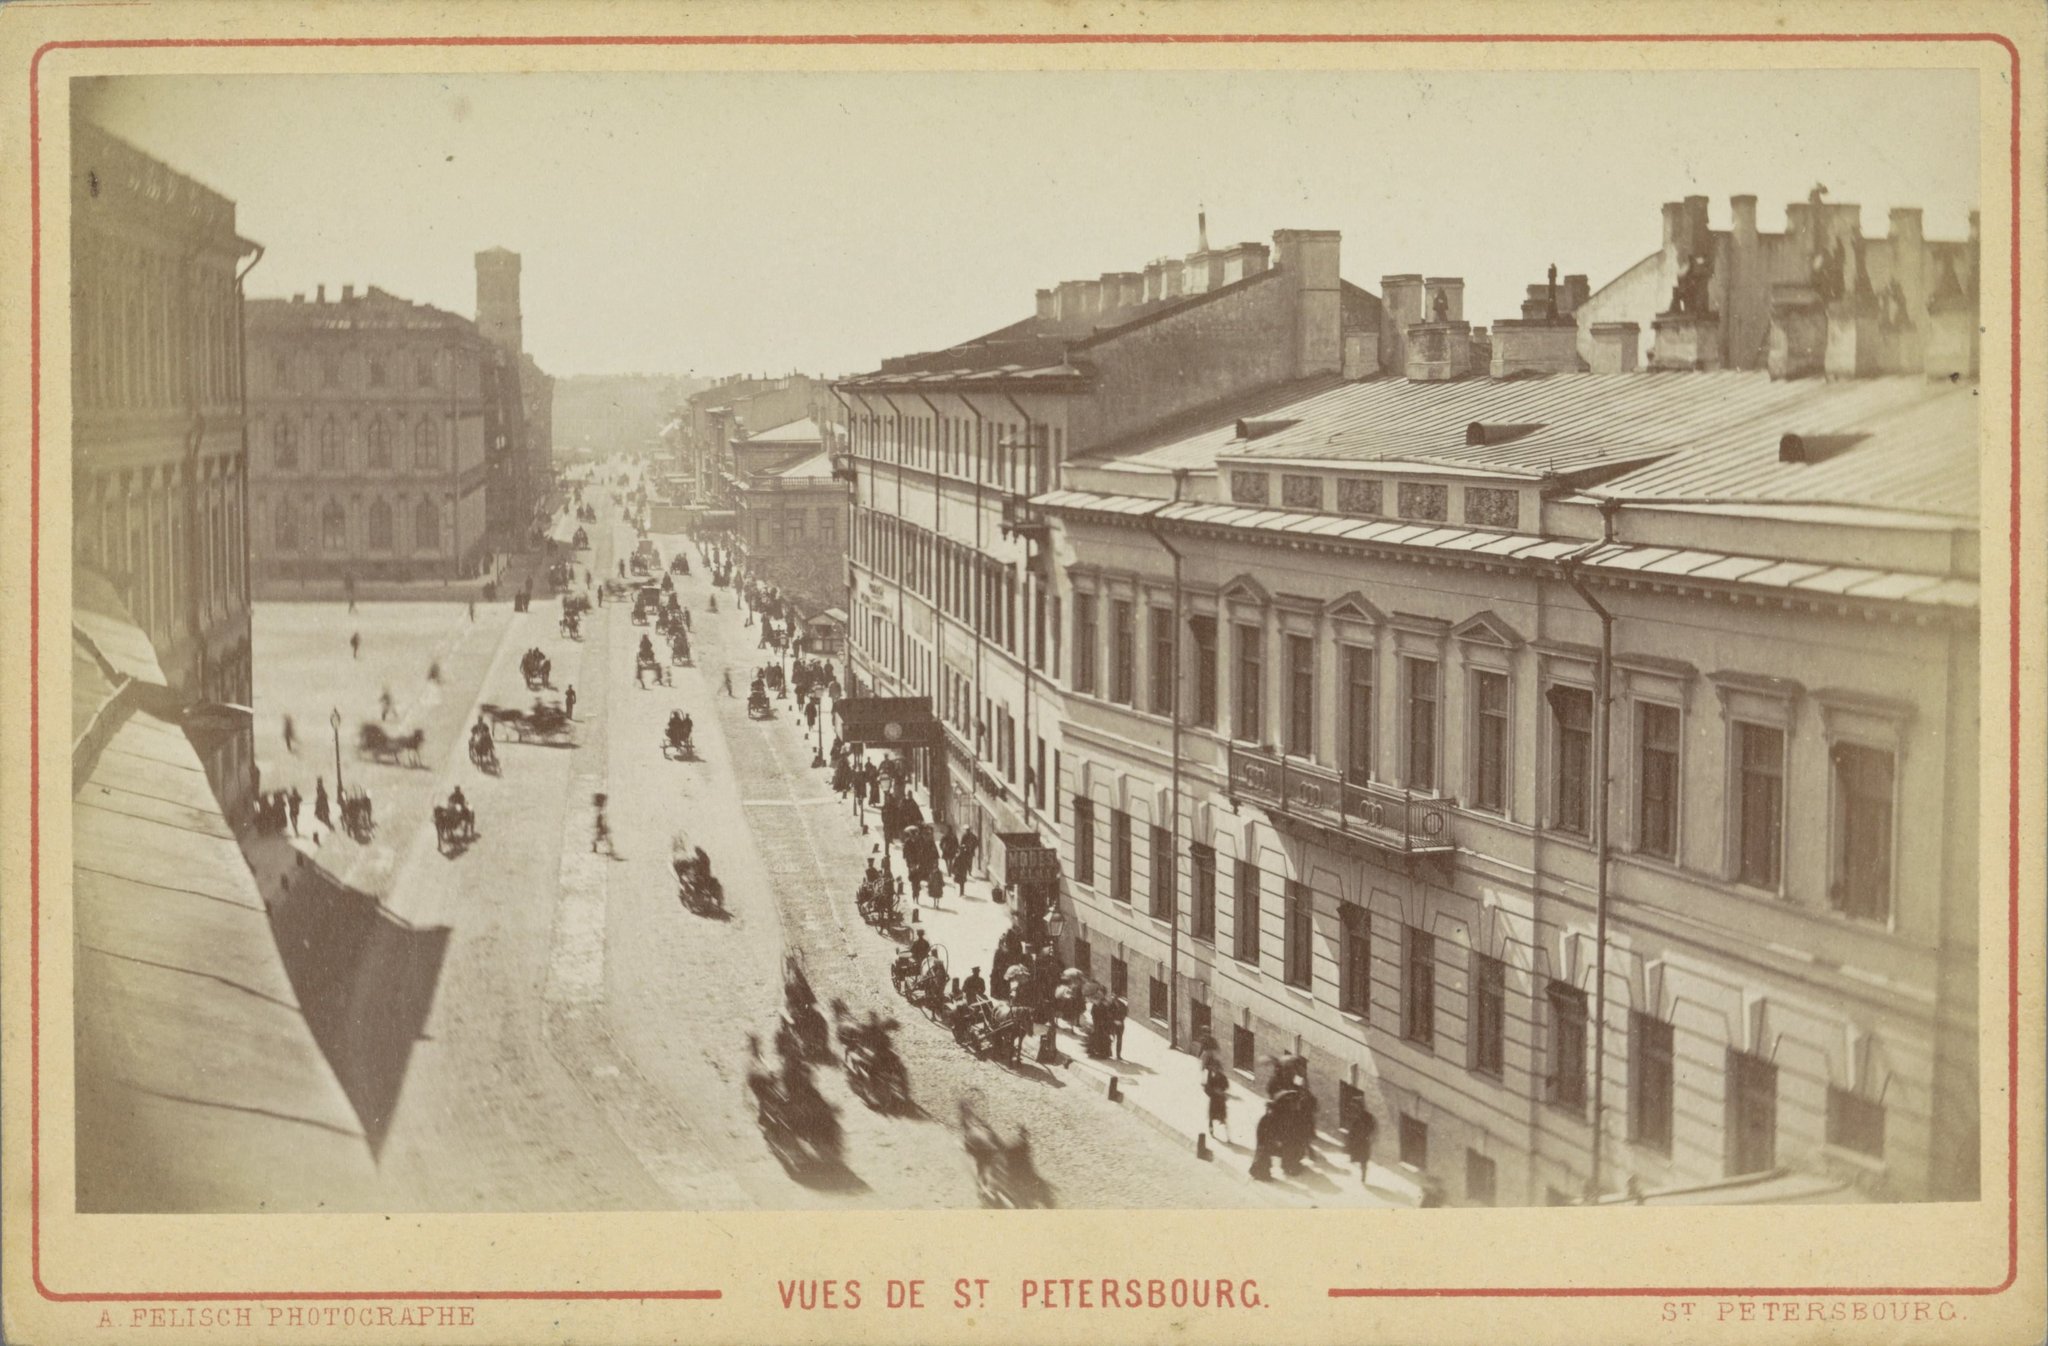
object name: cabinet photograph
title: Gezicht op een straat in Sint-Petersburg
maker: albert felisch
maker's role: fotograaf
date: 1880-1900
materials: cardboard, photographic support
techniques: albumen print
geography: sint-petersburg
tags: street (+ city(-scape) with figures, staffage)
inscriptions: inscription: ‘Rue grande Morsroy’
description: Onderdeel van Fotoalbum met opnames van Sint-Petersburg.